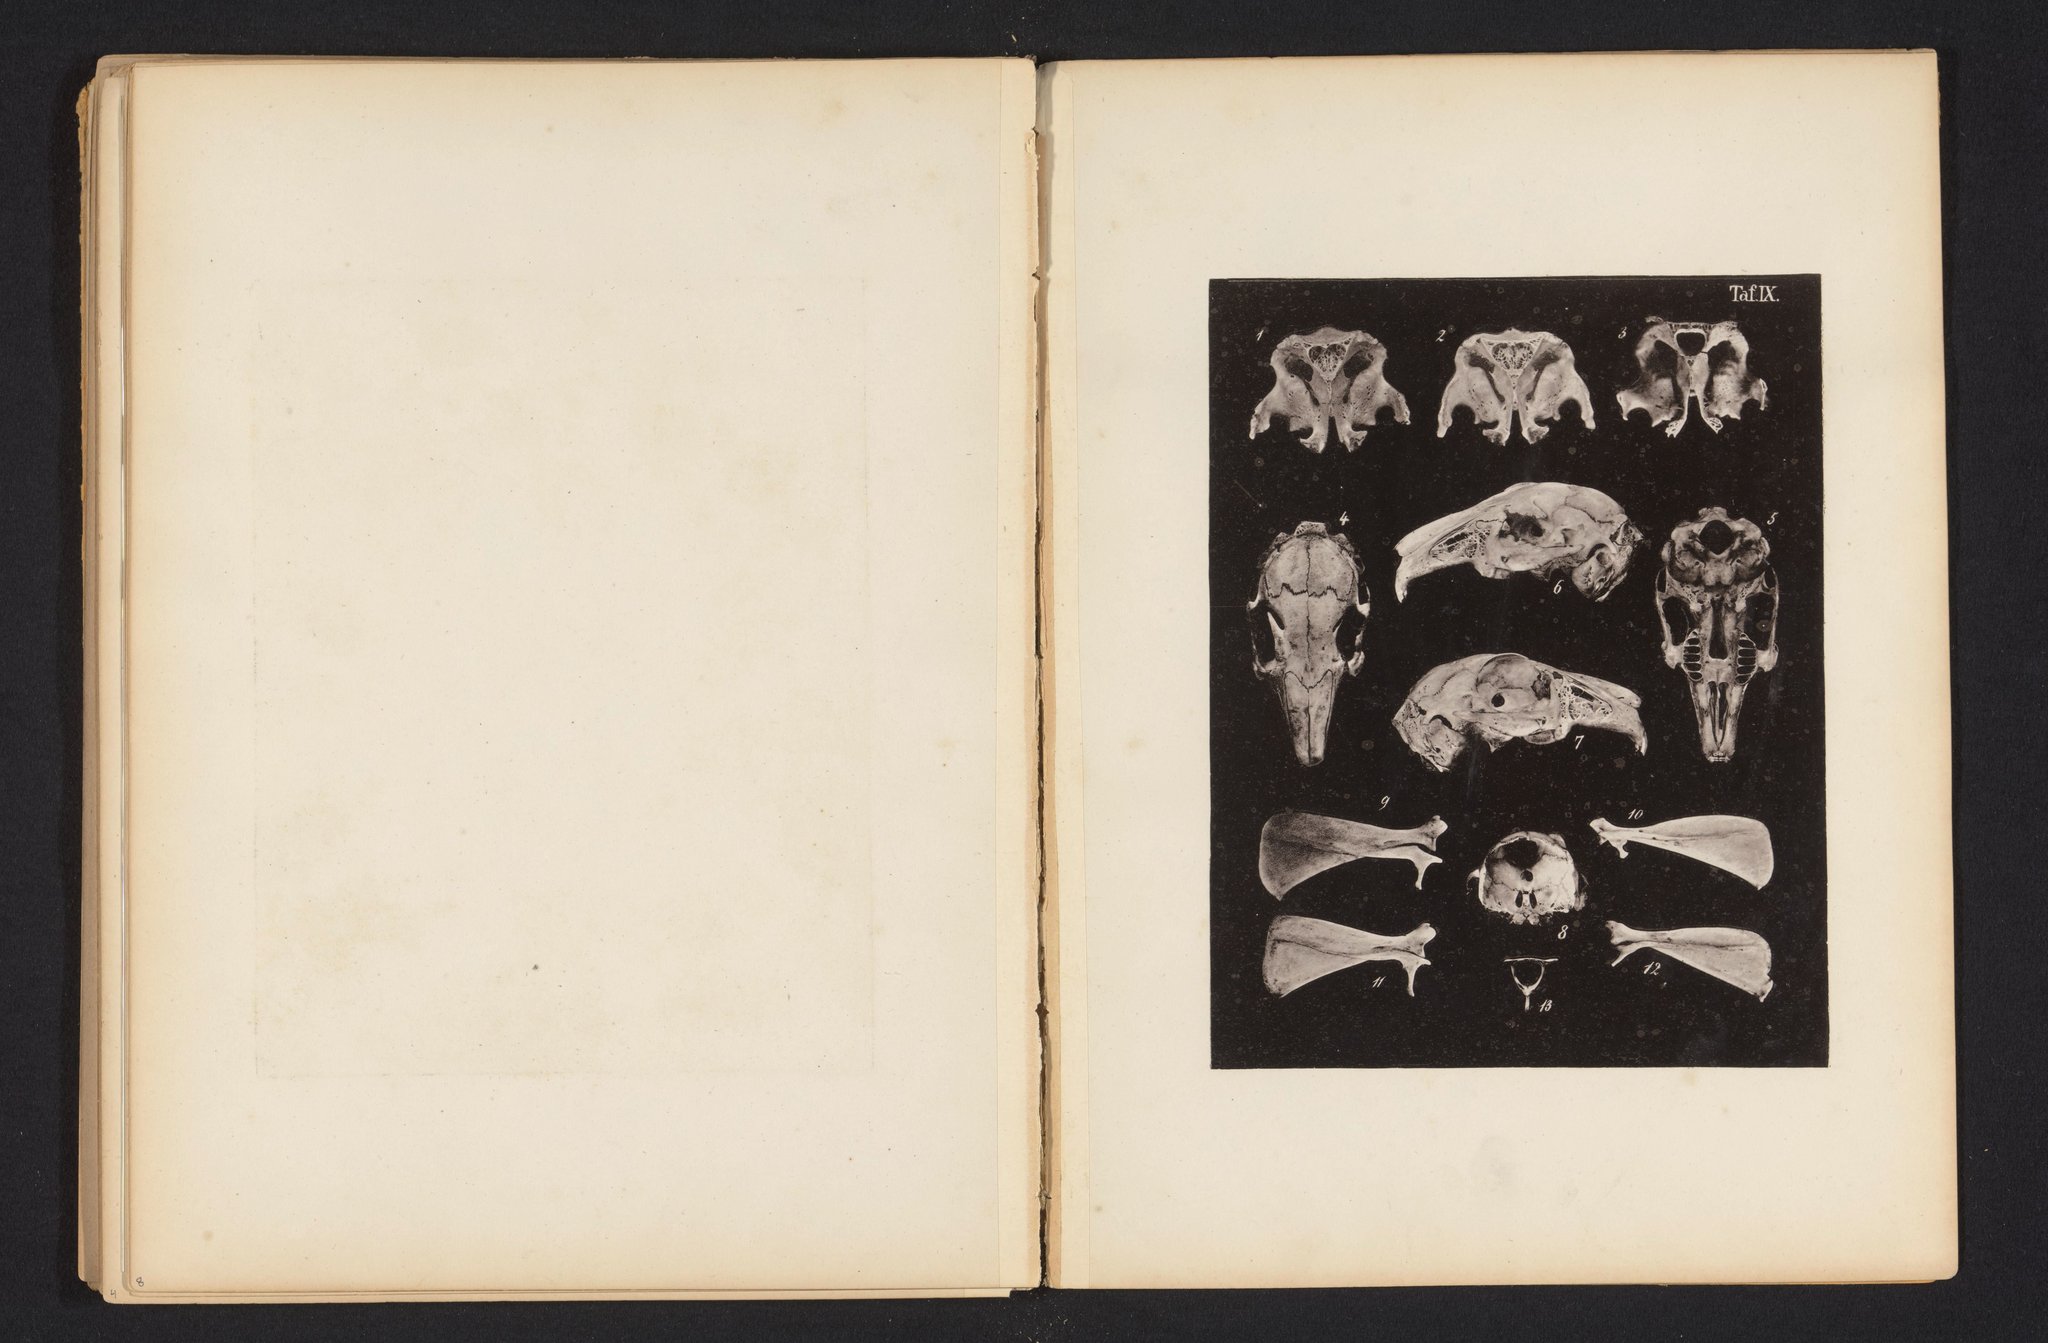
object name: page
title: Dertien aangezichten van onderdelen van een konijnenschedel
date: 1864-1874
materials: paper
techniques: photograph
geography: germany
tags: (human) skull, rodents: rabbit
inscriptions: number: ‘Taf. IX. 1 2 3 4 5 6 7 8 9 10 11 12 13’